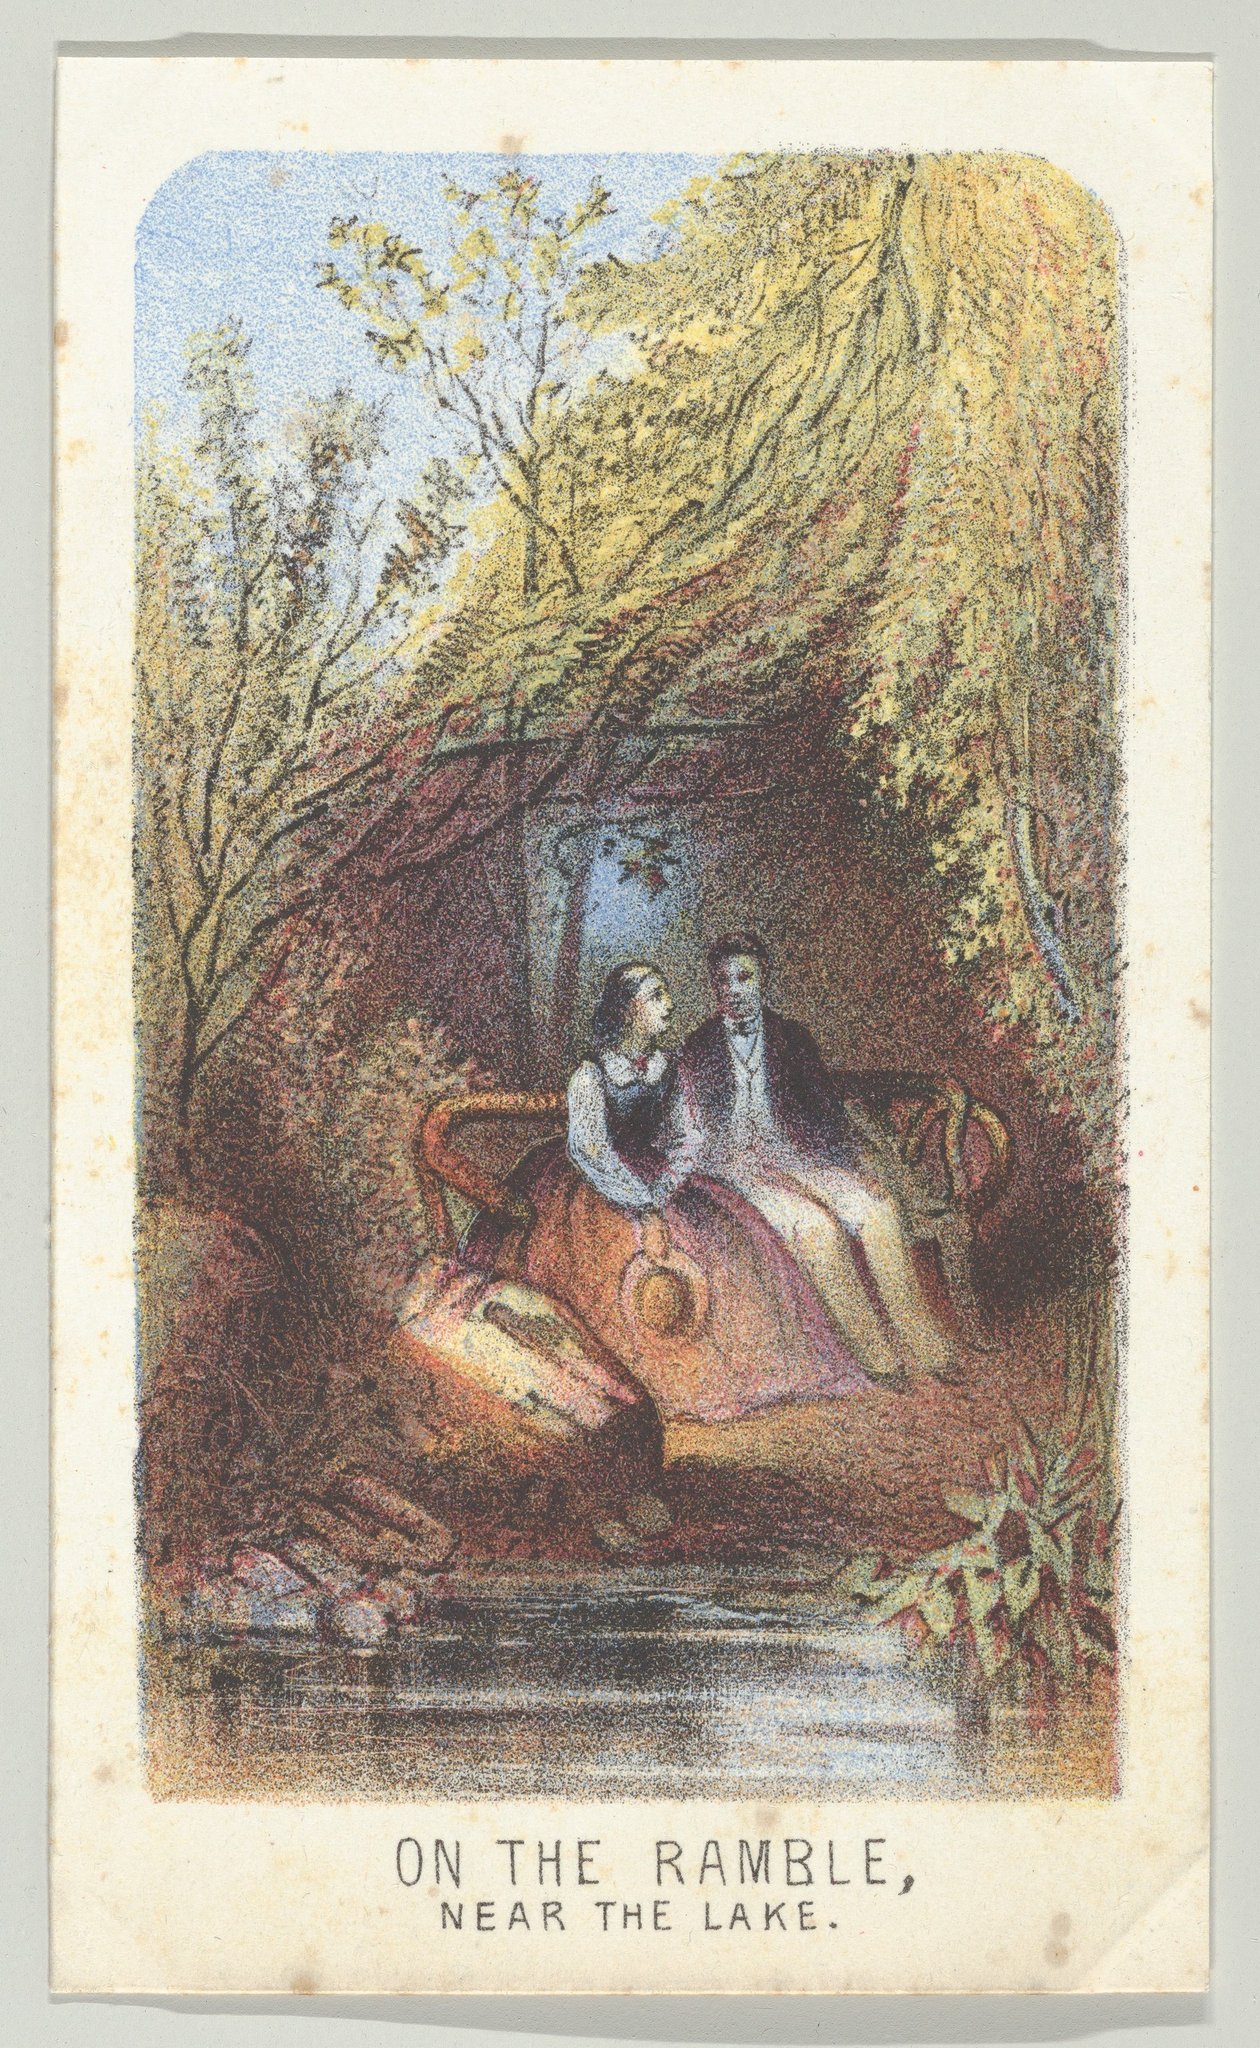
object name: print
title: On the Ramble, Near the Lake, from the series, Views in Central Park, New York, Part 3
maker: louis prang & co.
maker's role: publisher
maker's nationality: american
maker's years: 1800-1950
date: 1864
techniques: lithograph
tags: men,women,lakes